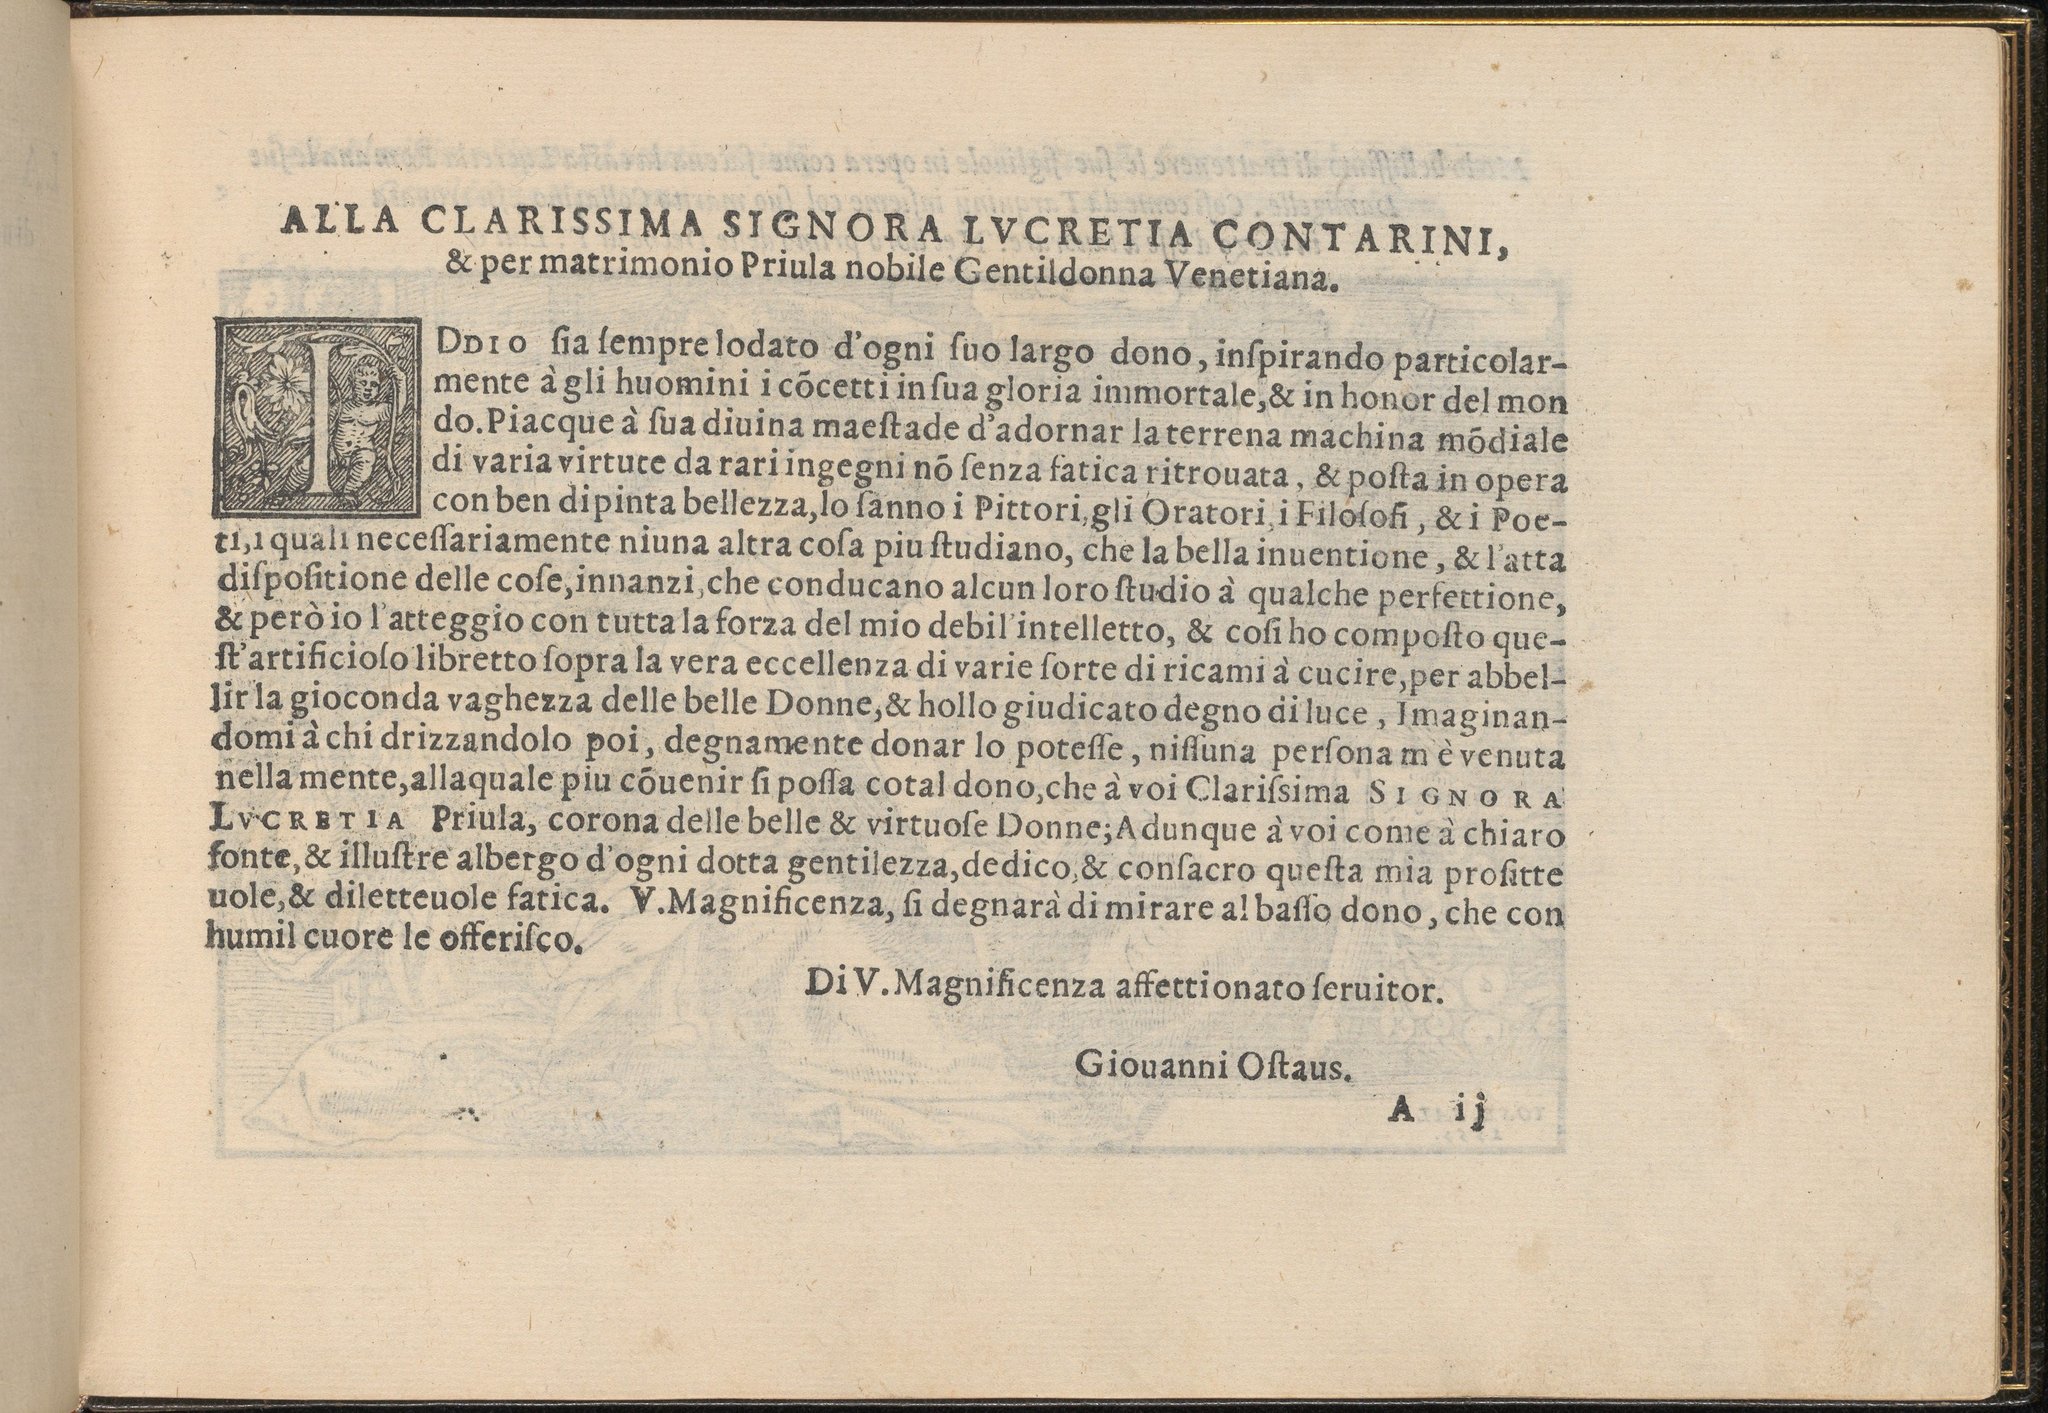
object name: book print ornament architecture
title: La Vera Perfettione del Disegno di varie sorti di recami, page 2 (recto)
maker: giovanni ostaus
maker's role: publisher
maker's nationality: italian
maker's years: 1507-1607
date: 1567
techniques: woodcut